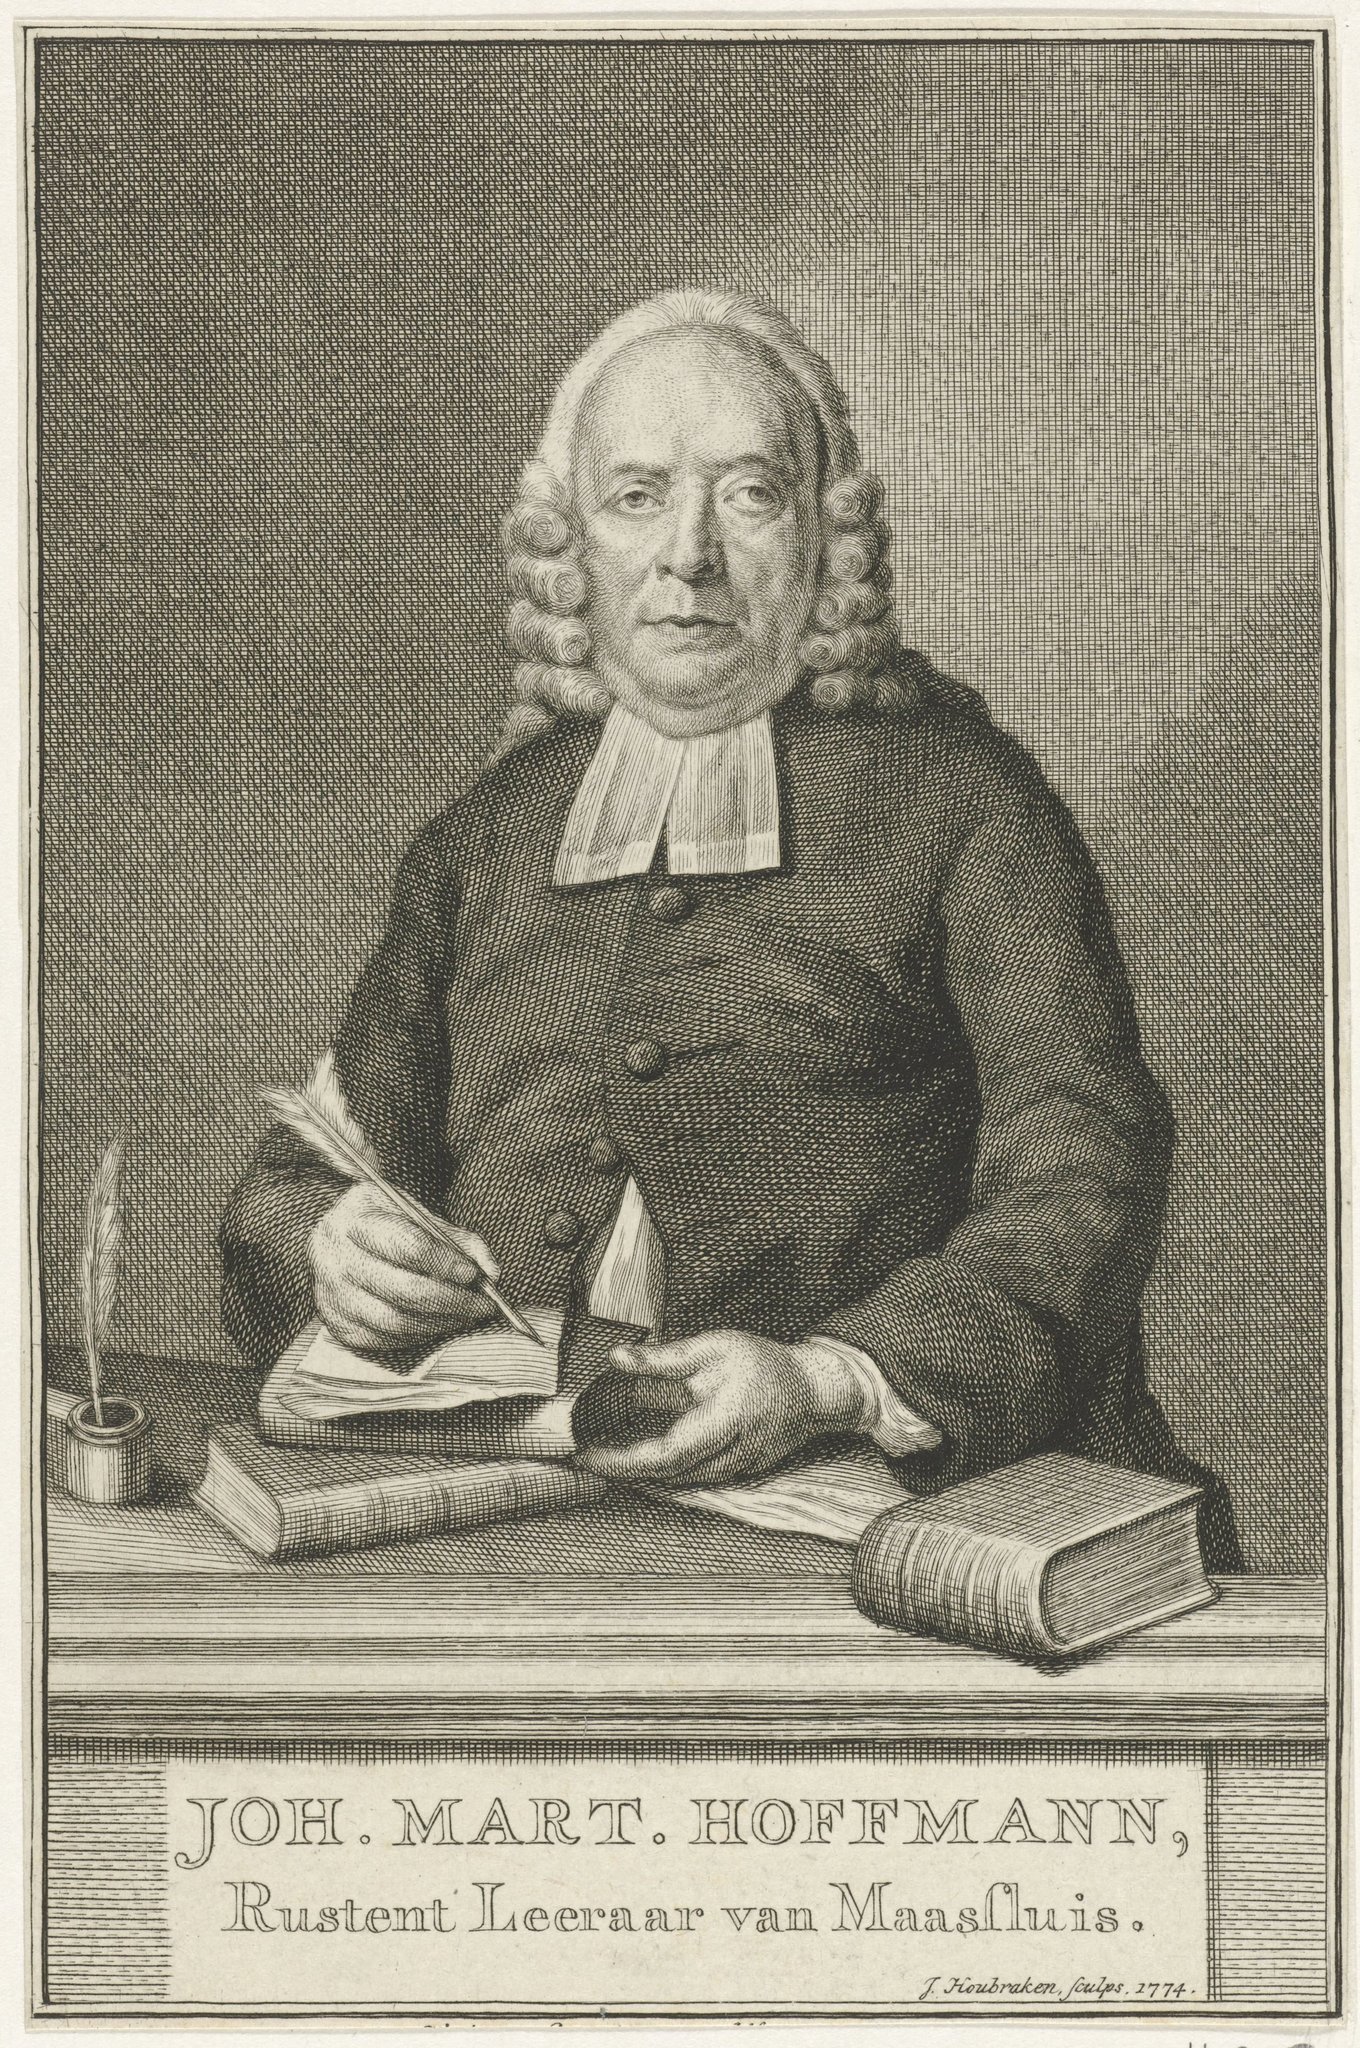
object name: print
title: Joh. Mart. Hoffmann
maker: jacob houbraken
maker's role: draughtsman, print maker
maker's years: 1698-1780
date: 1774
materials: paper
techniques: engraving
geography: amsterdam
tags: quill, ink-well, writing tools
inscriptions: collector's mark: Lugt 2228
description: Portret ten halven lijve van Johannes Martinus Hoffman, achter een tafel waarop boeken, papier en een inktpot. In zijn rechterhand houdt hij een schrijfveer. Onder het portret zijn naam en gegevens in twee regels in het Nederlands.